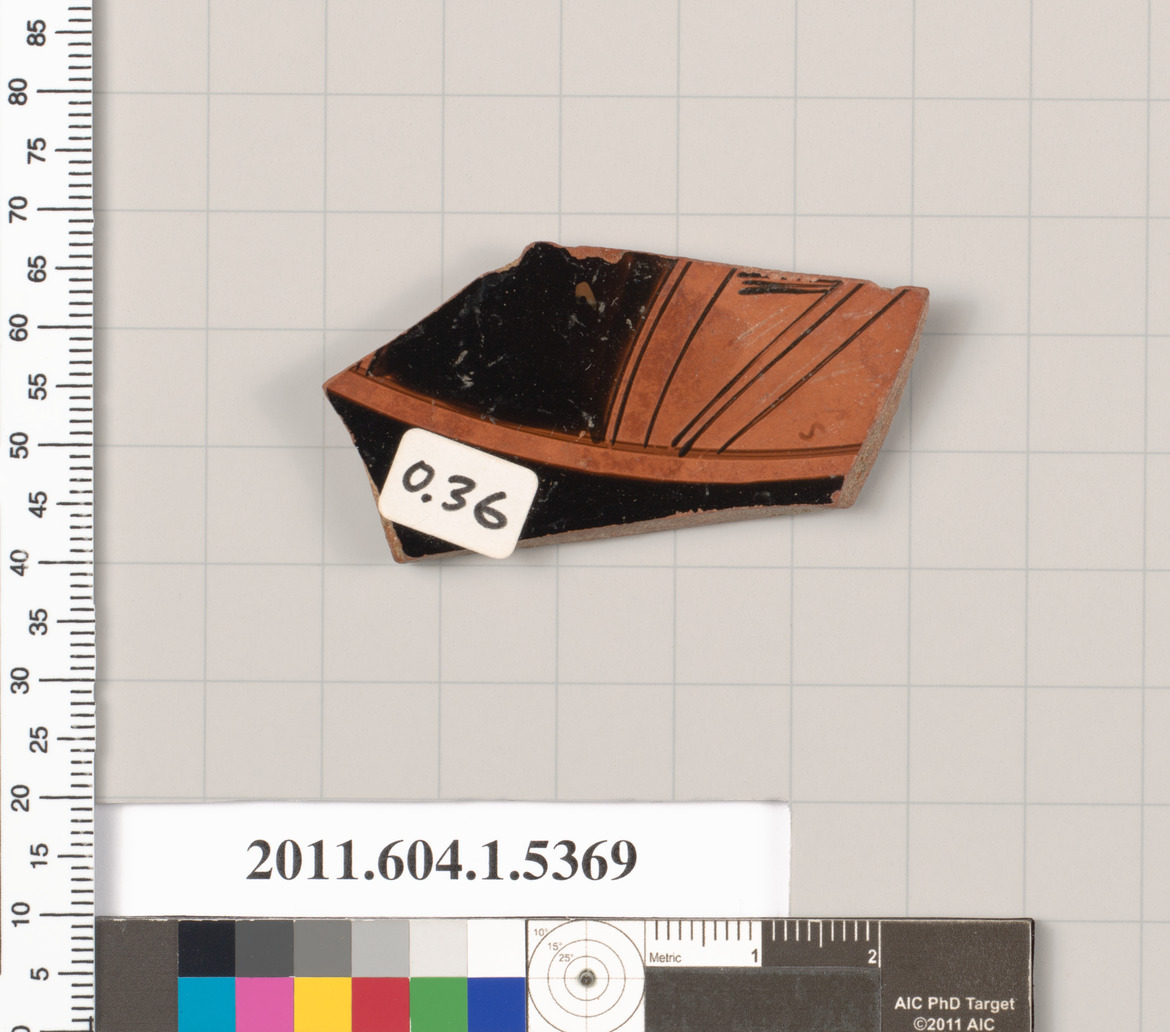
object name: kylix fragment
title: Terracotta fragment of a kylix (drinking cup)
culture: greek, attic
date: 500-480 BCE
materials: terracotta